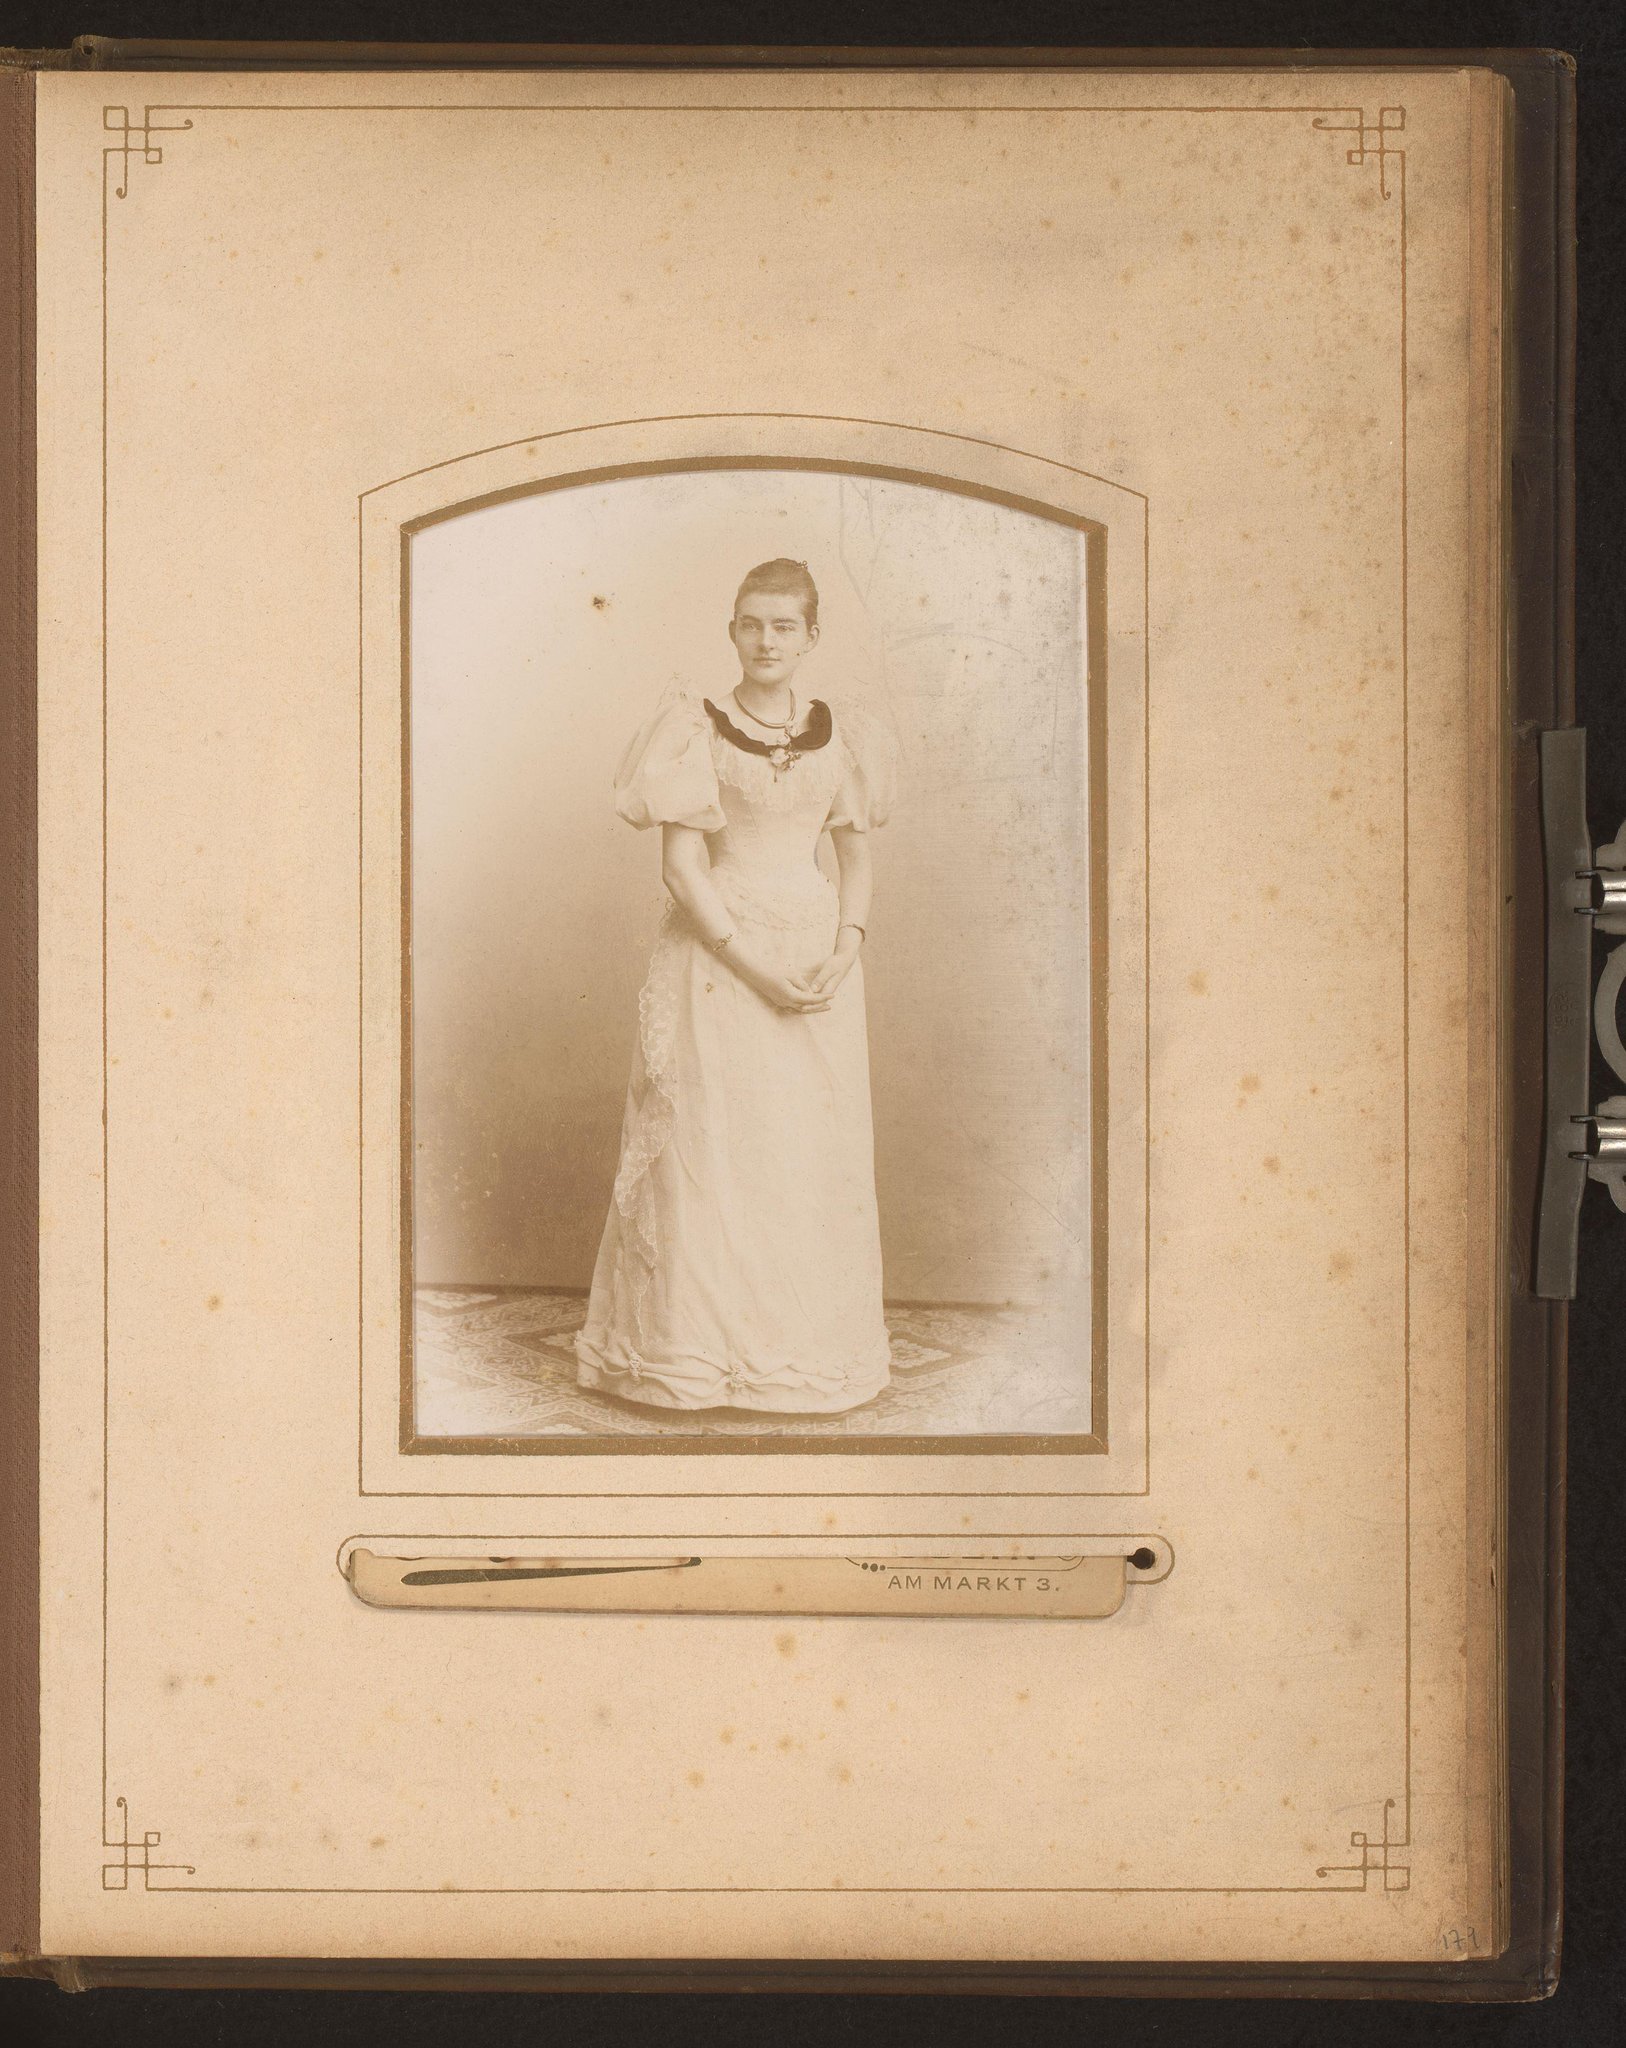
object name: cabinet photograph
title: Portret van een vrouw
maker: e. ziemer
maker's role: fotograaf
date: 1880-1910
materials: cardboard, photographic support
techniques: collodion silver print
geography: koszalin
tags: historical persons - bb - woman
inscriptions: inscription: ‘E. Ziemer/ Cösliln/ Am Markt 3’